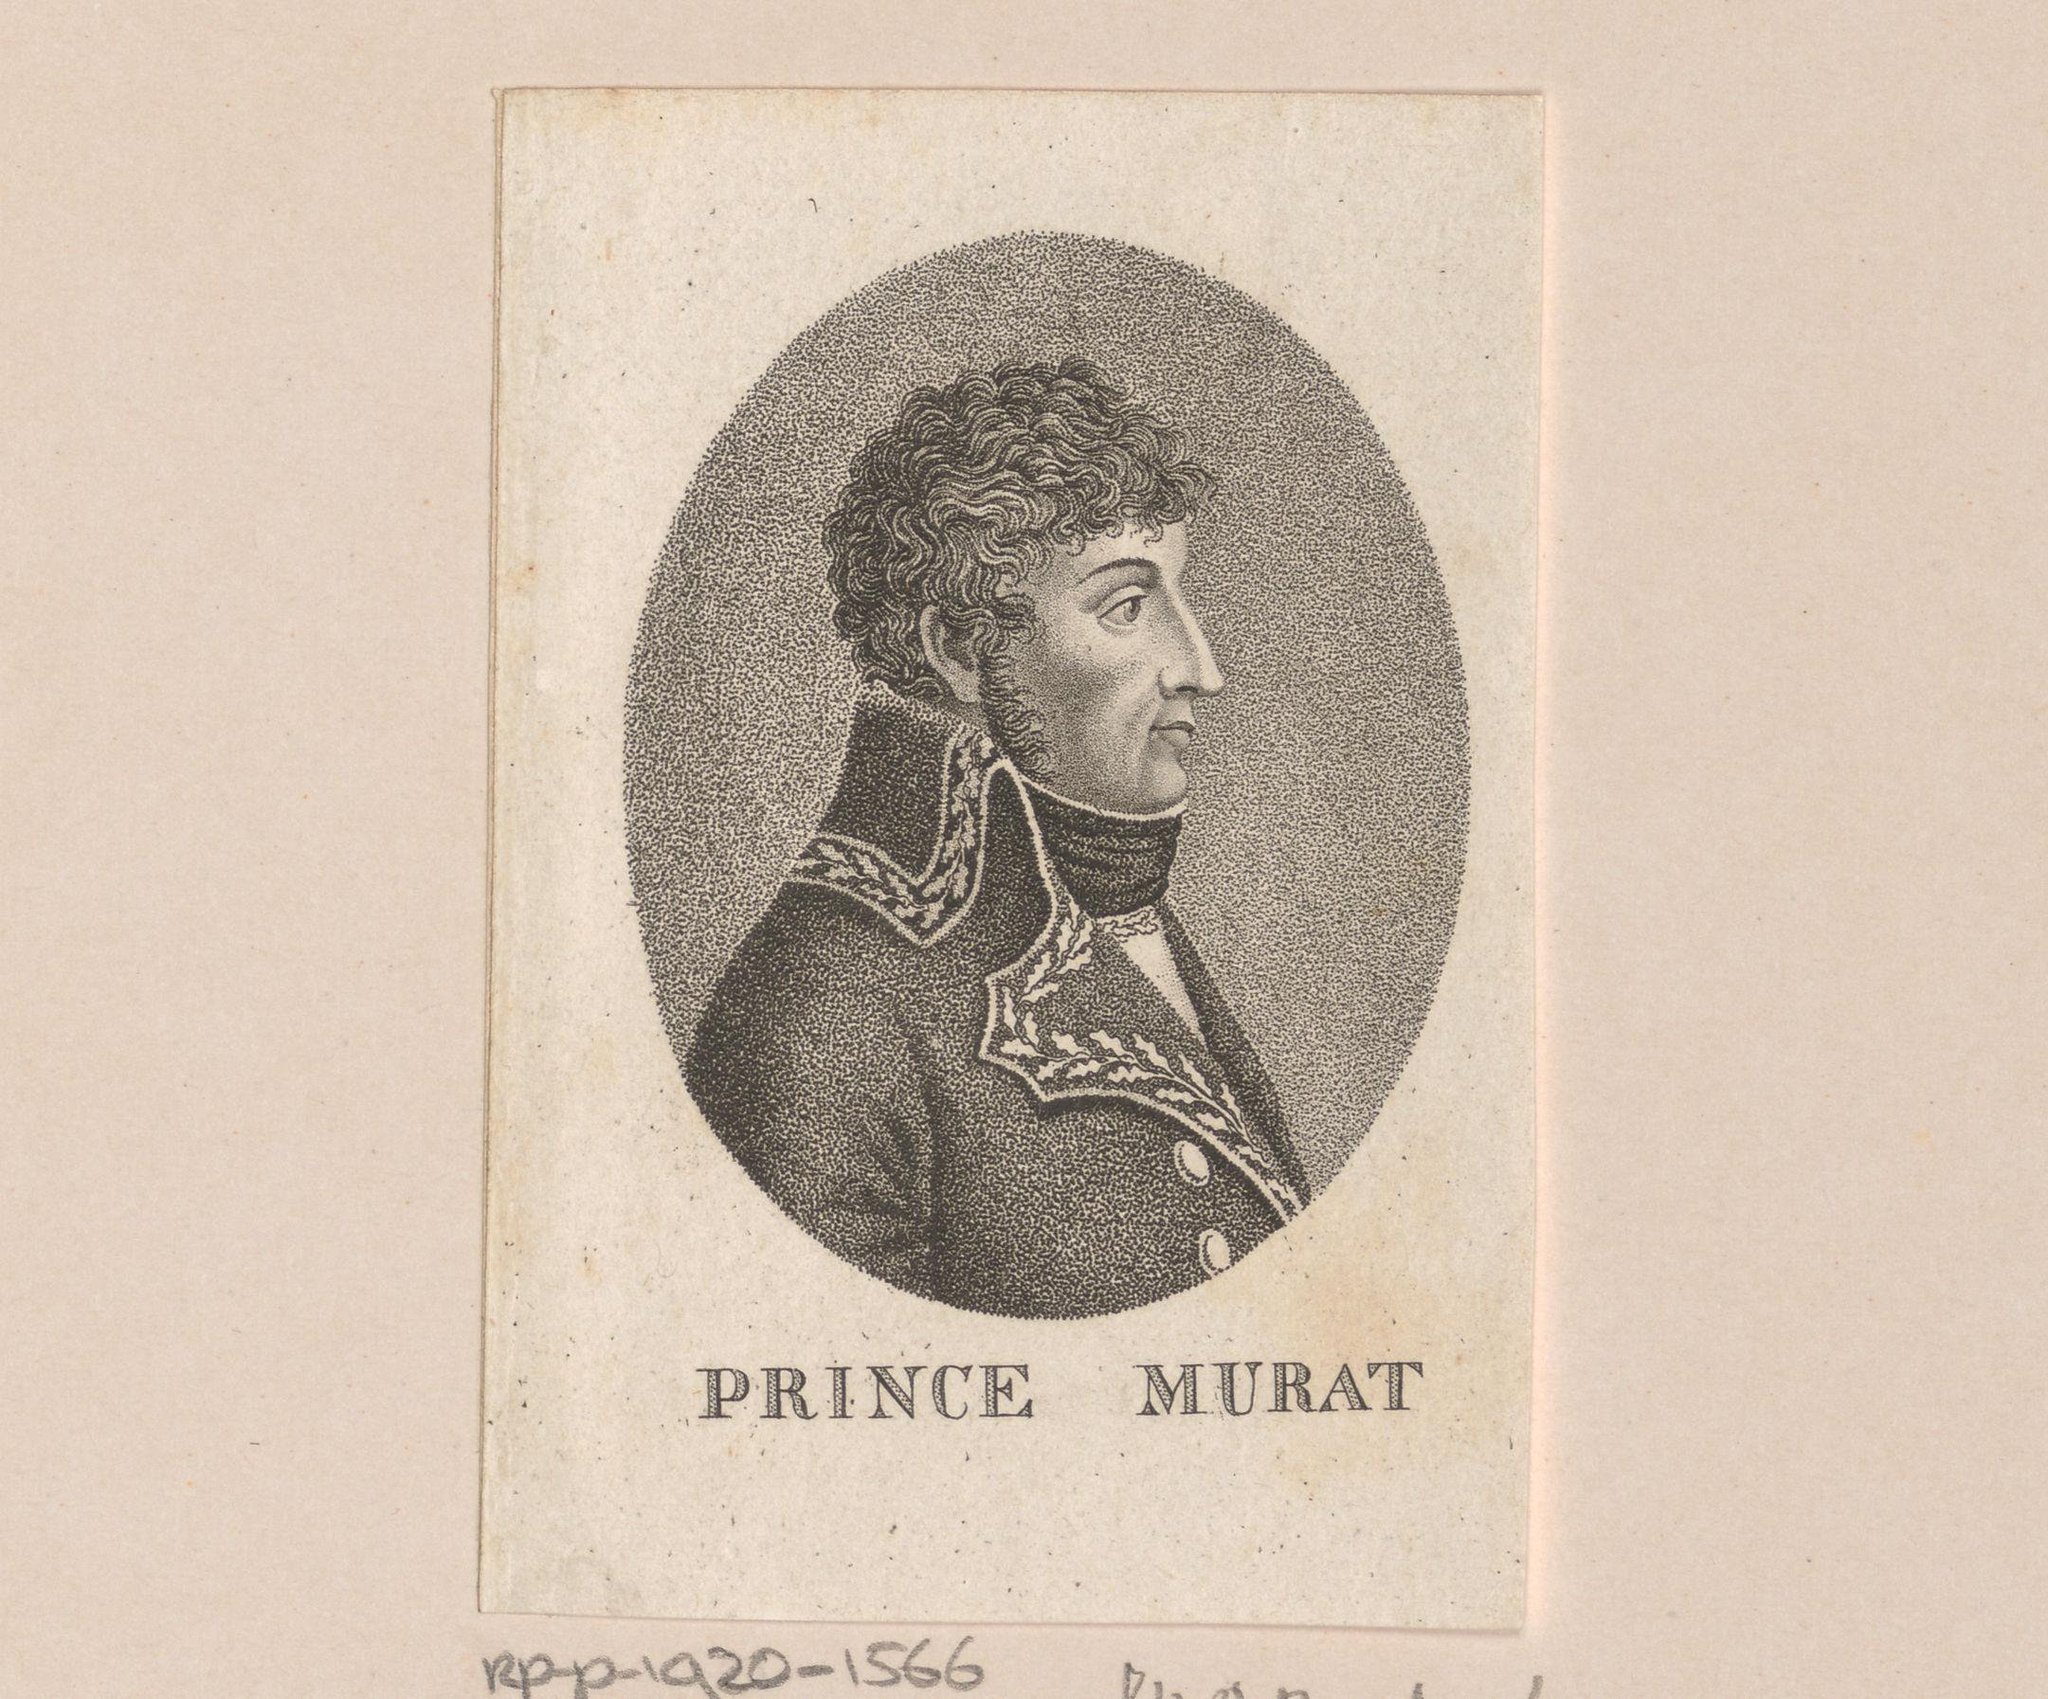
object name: print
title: Portret van Joachim Murat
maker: Anonymous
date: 1805-1815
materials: paper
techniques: etching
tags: pizzo, historical persons, emperor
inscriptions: collector's mark: Lugt 2228